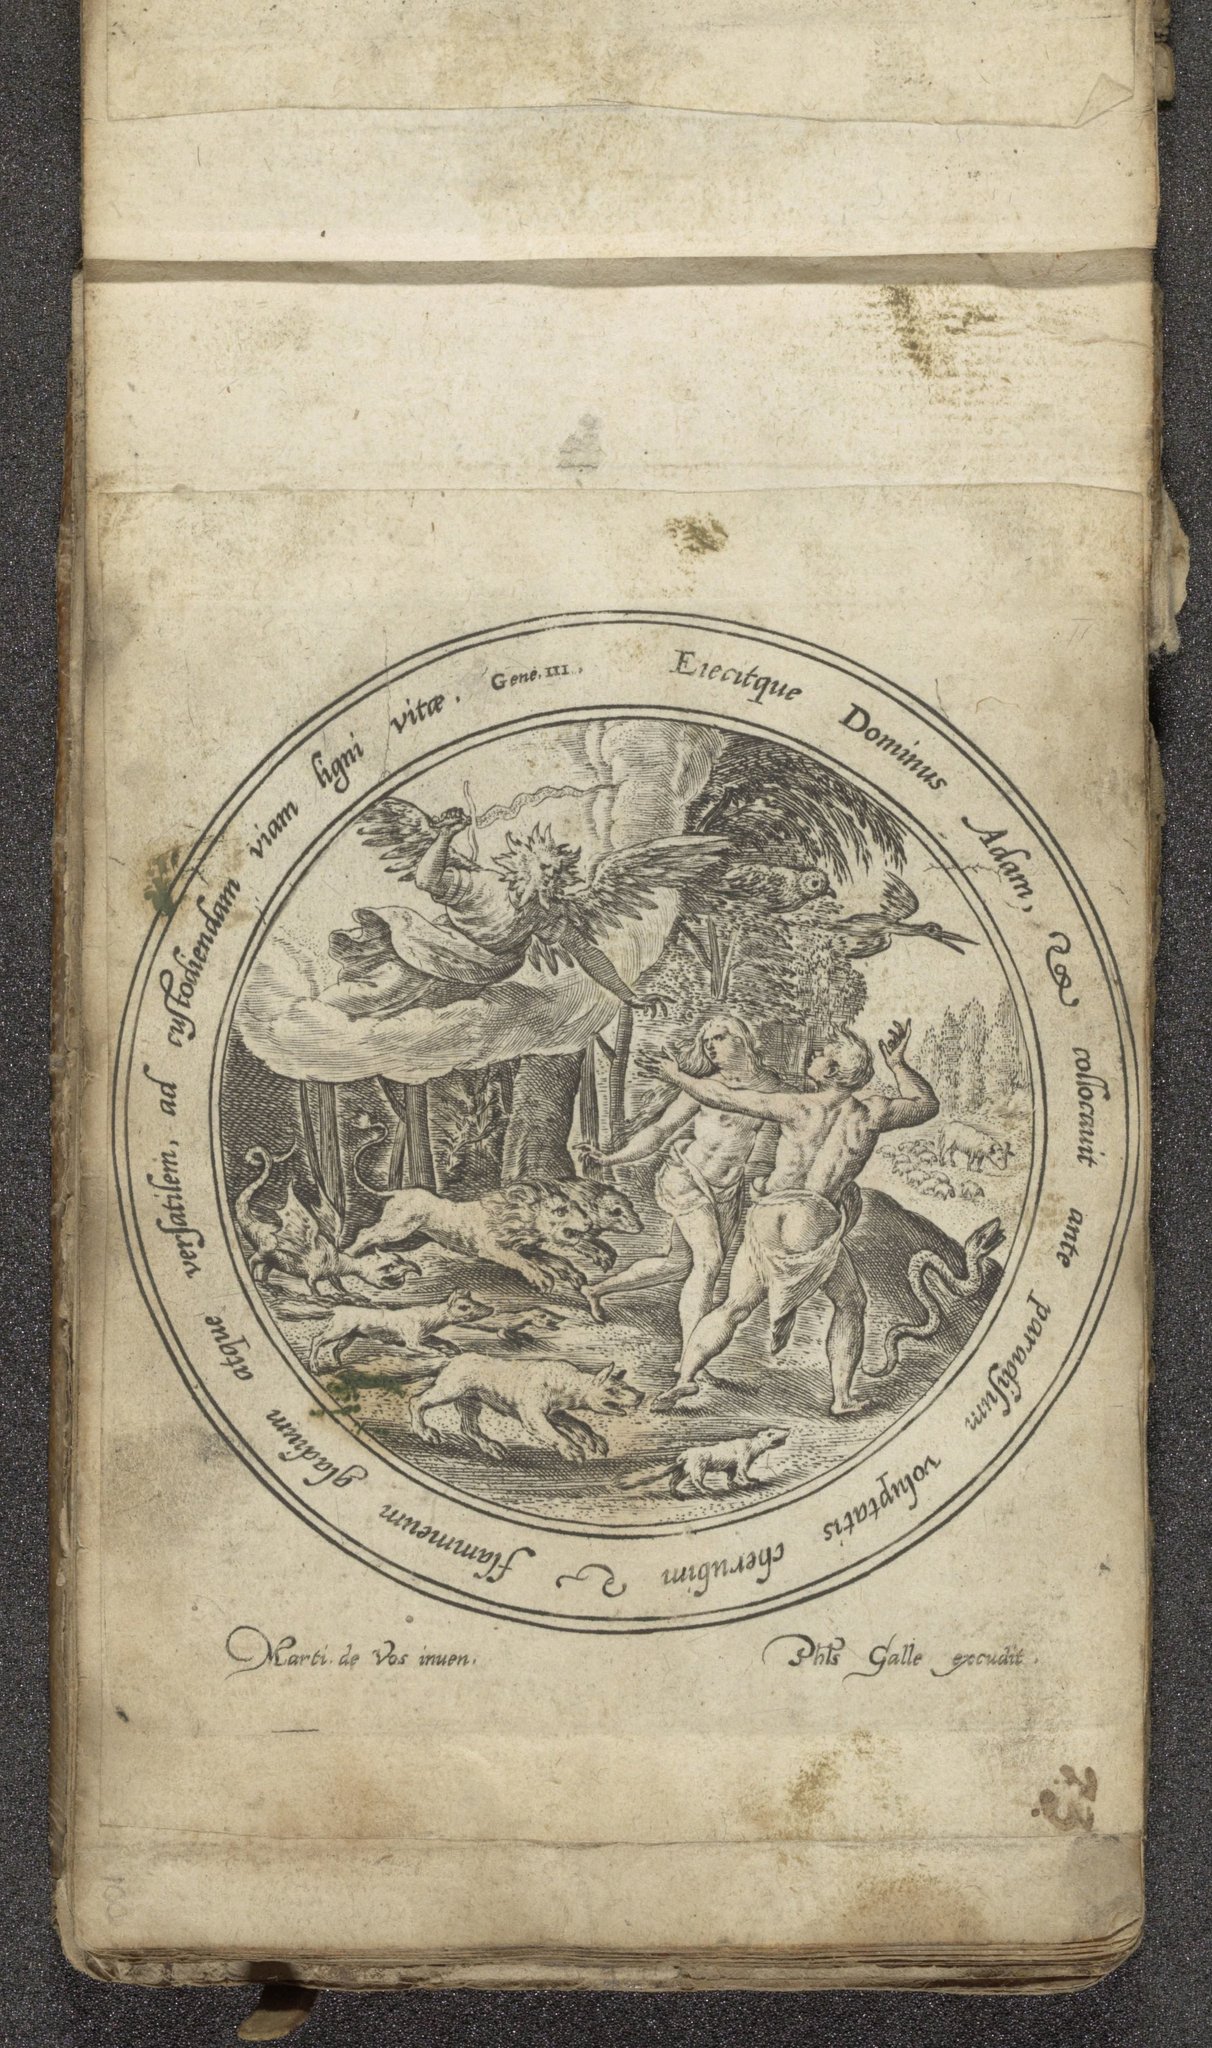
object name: album leaf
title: Expulsion from Paradise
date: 1580-1588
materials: paper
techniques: engraving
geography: antwerp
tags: an angel chases adam and eve out of paradise with a (flaming) sword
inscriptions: inscription: ‘73’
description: De engel verdrijft Adam en Eva met zijn zwaard uit het paradijs. God overhandigde Adam en Eva kleren van dierenhuiden, om hun naaktheid te bedekken. In het randschrift van de omlijsting een Bijbelcitaat uit Gen. in het Latijn. De prent maakt deel uit van een album.